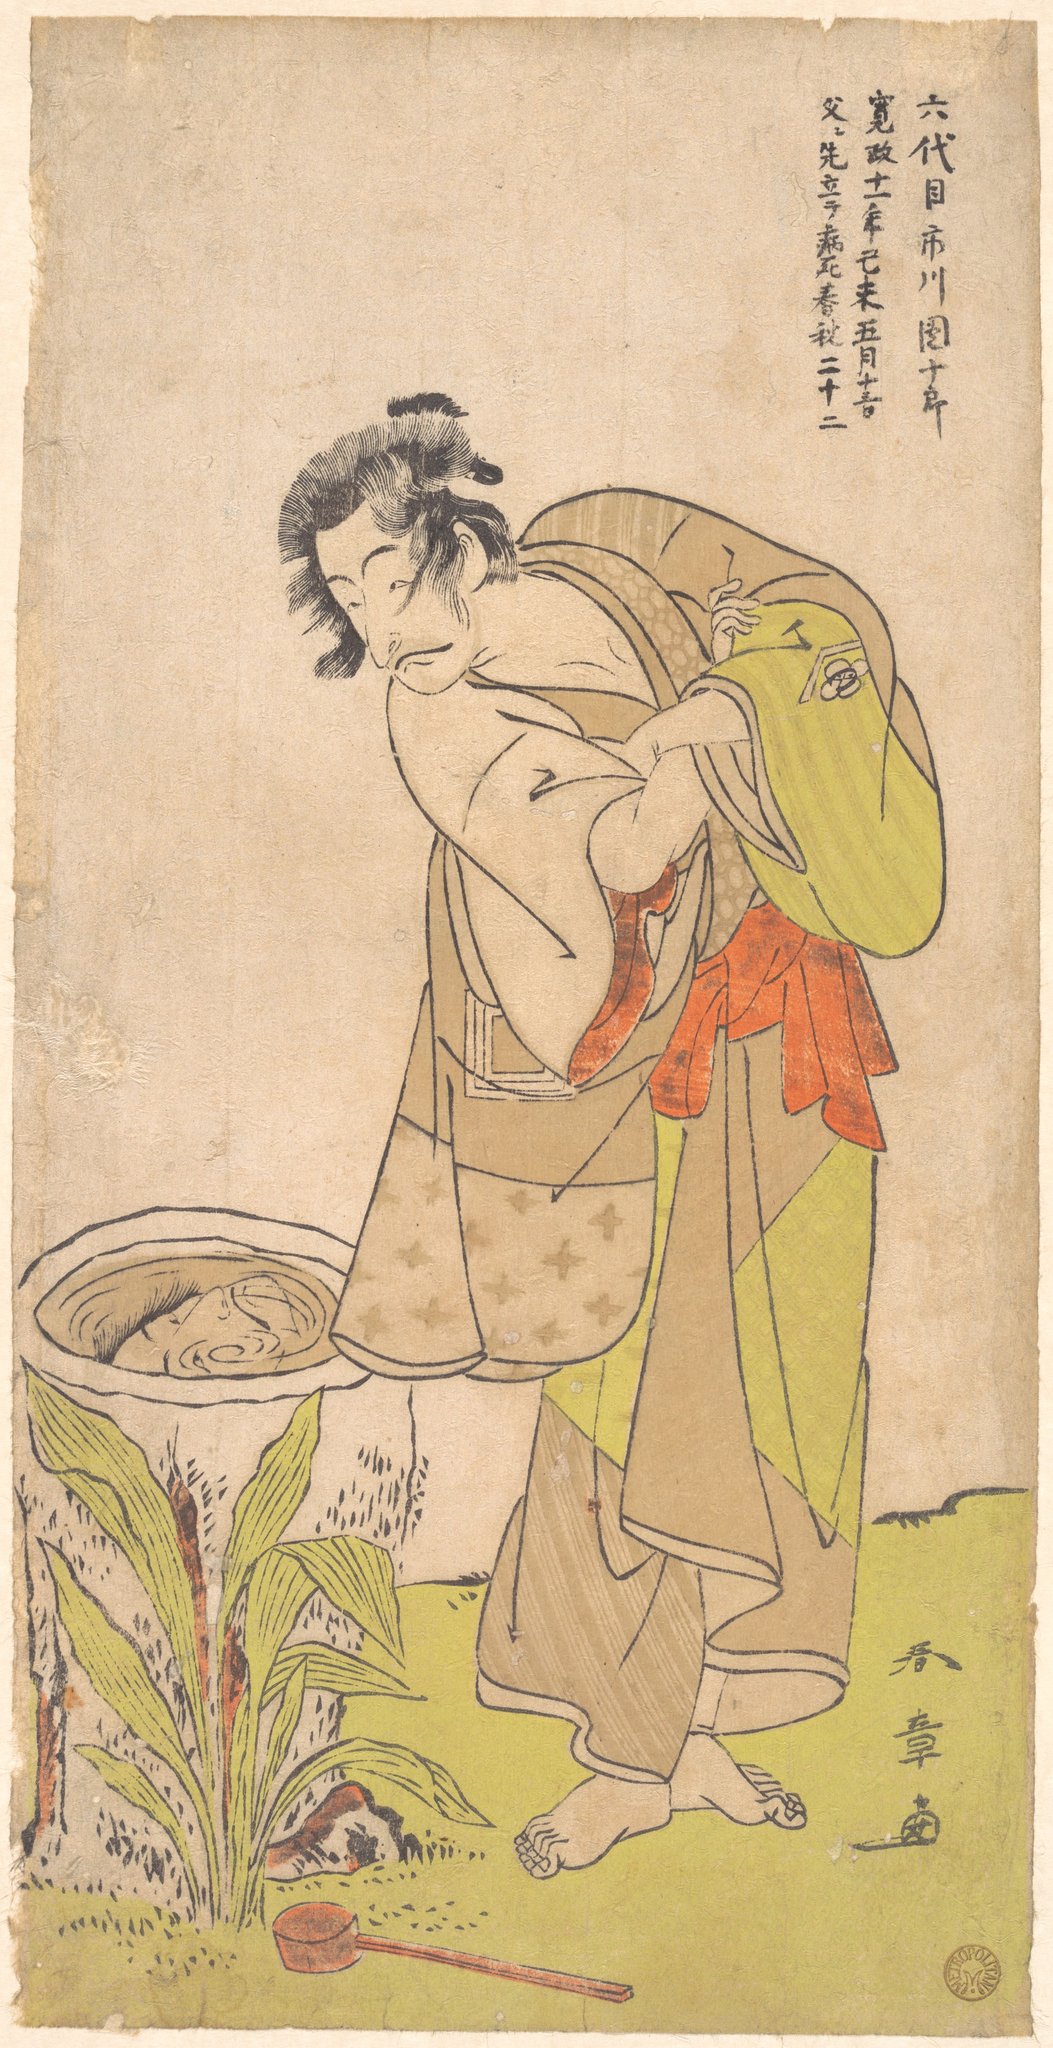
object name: woodblock print nishiki e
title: The Kabuki Actor Ichikawa Danjūrō V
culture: japanese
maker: katsukawa shunshō 勝川春章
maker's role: artist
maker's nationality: japanese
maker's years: 1726-1792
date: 1773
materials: ink, paper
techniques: nishiki e, woodblock print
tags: men,actors